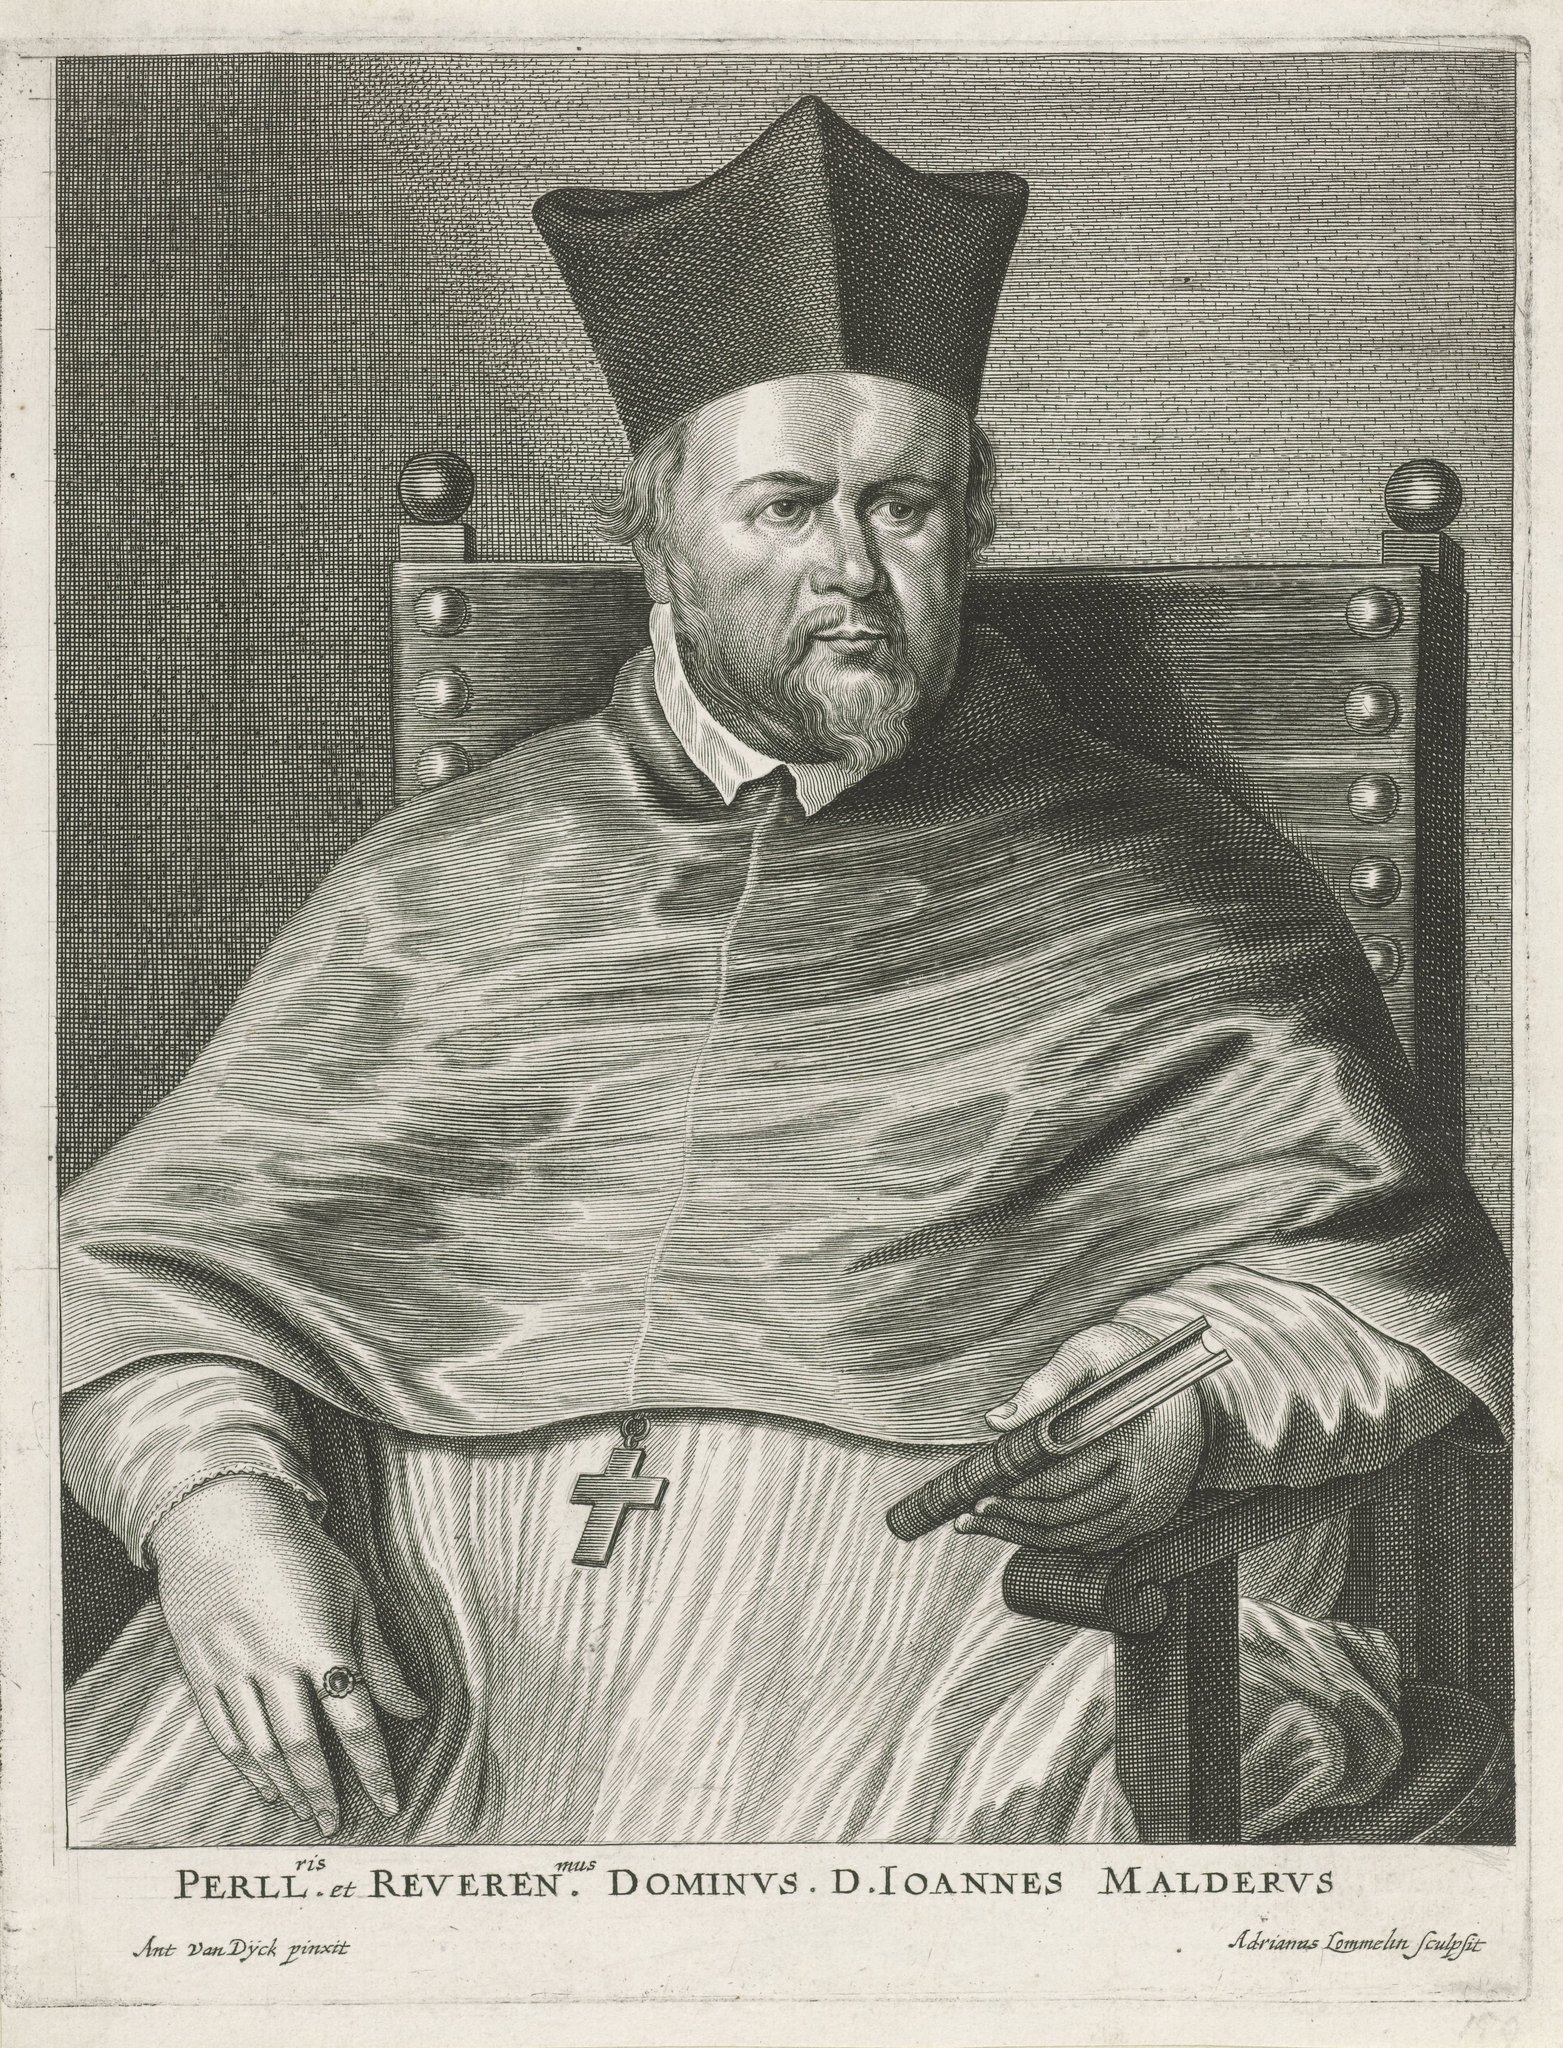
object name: print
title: Portret van Johannes Malderus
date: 1630-1677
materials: paper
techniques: engraving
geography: antwerp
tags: johannes malderus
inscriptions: collector's mark: Lugt 240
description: Portret van Johannes Malderus, bisschop van Antwerpen.